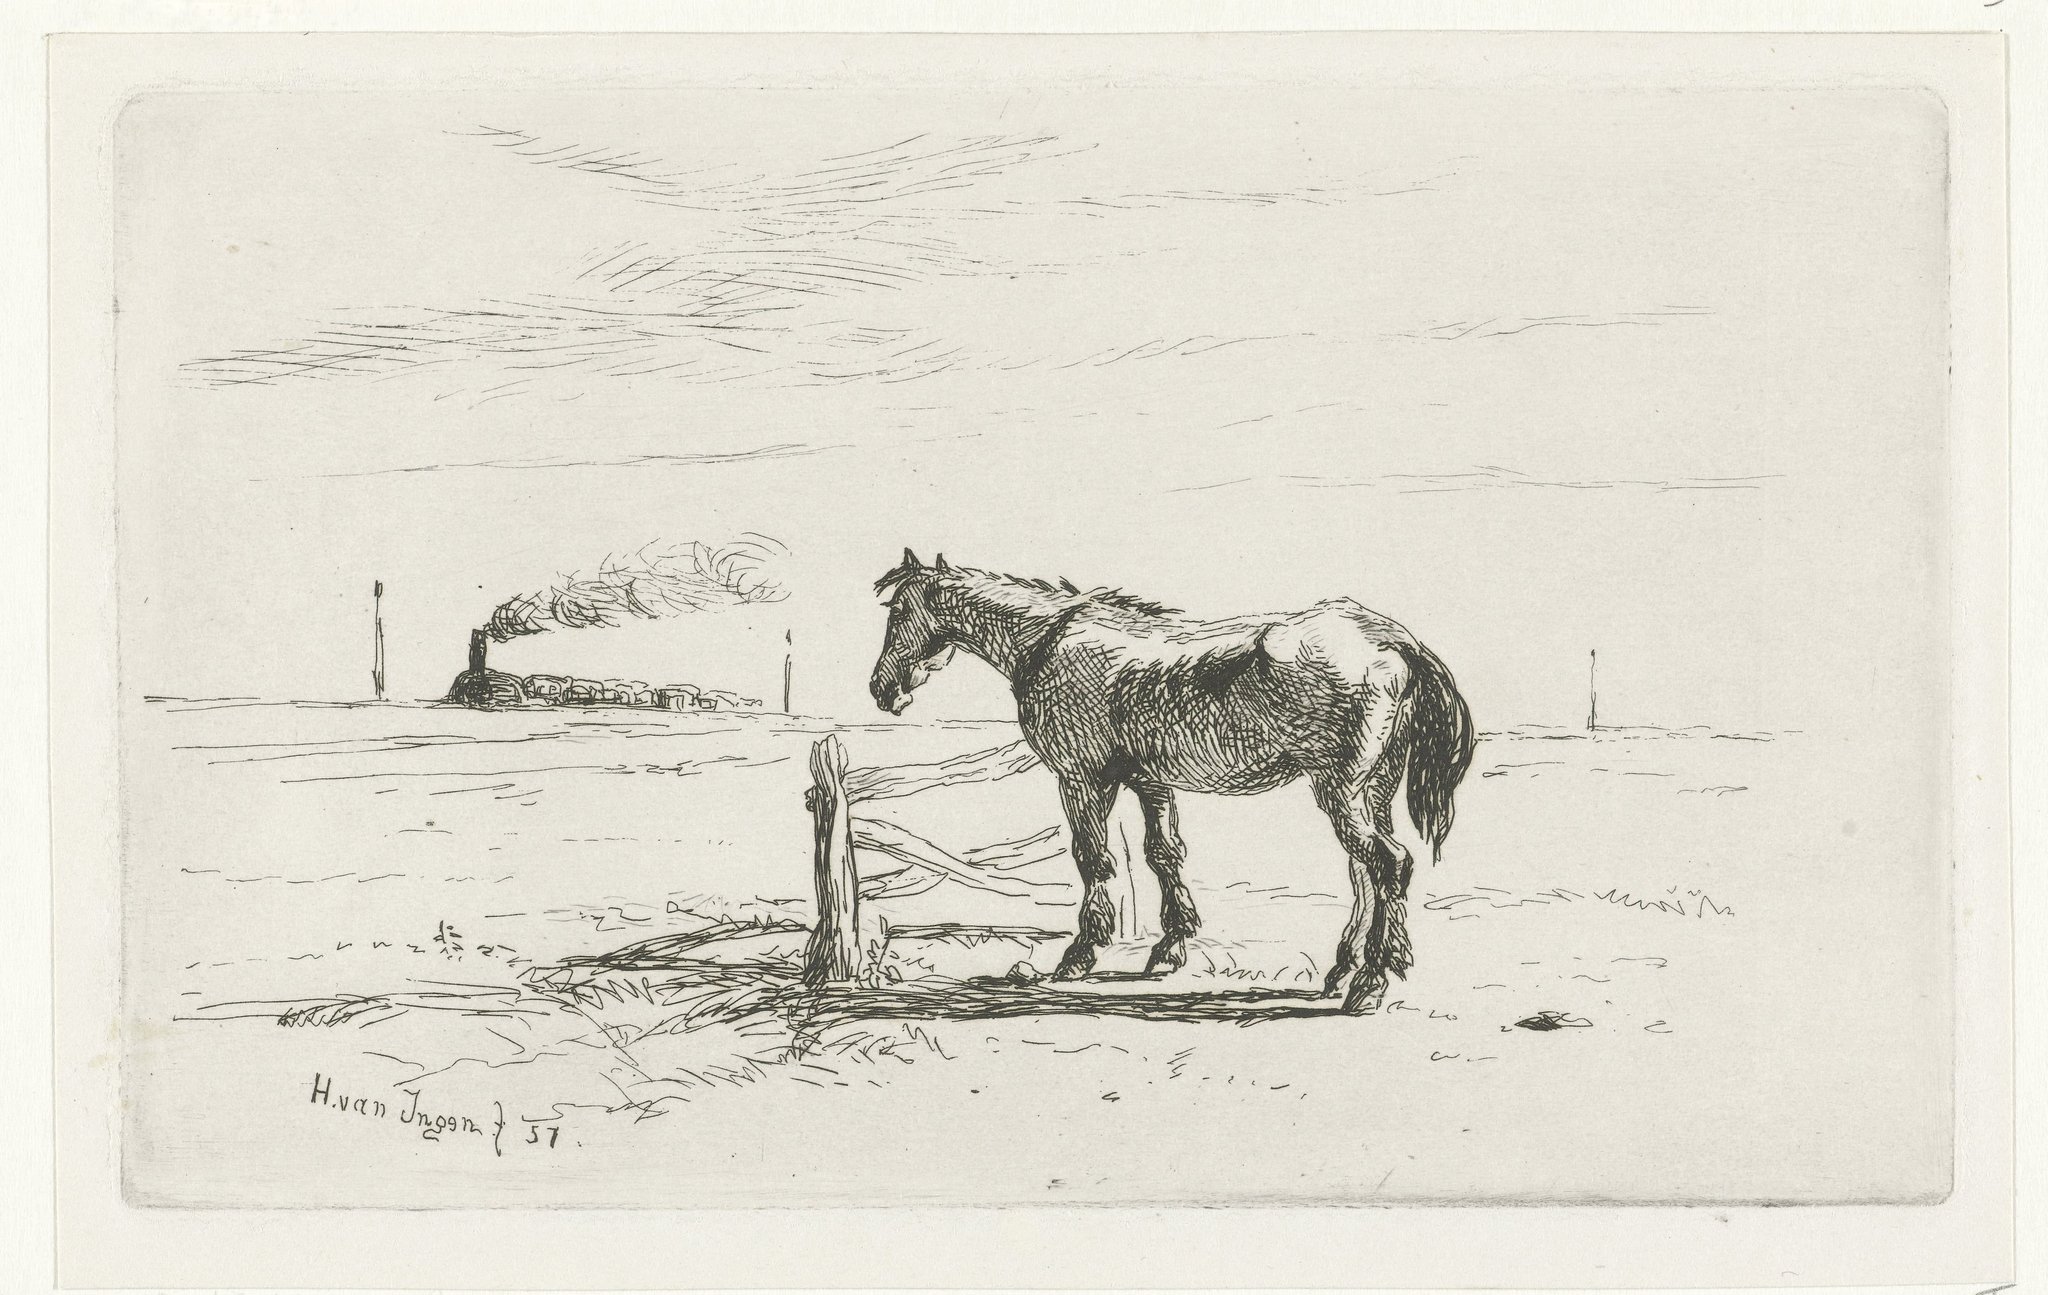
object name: print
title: Paard in een weiland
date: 1857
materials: paper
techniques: etching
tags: horses and kindred animals, steam locomotive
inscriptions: collector's mark: Lugt 2228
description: Paard bij een hek in een weiland. Aan de horizon rijdt een stoomtrein.